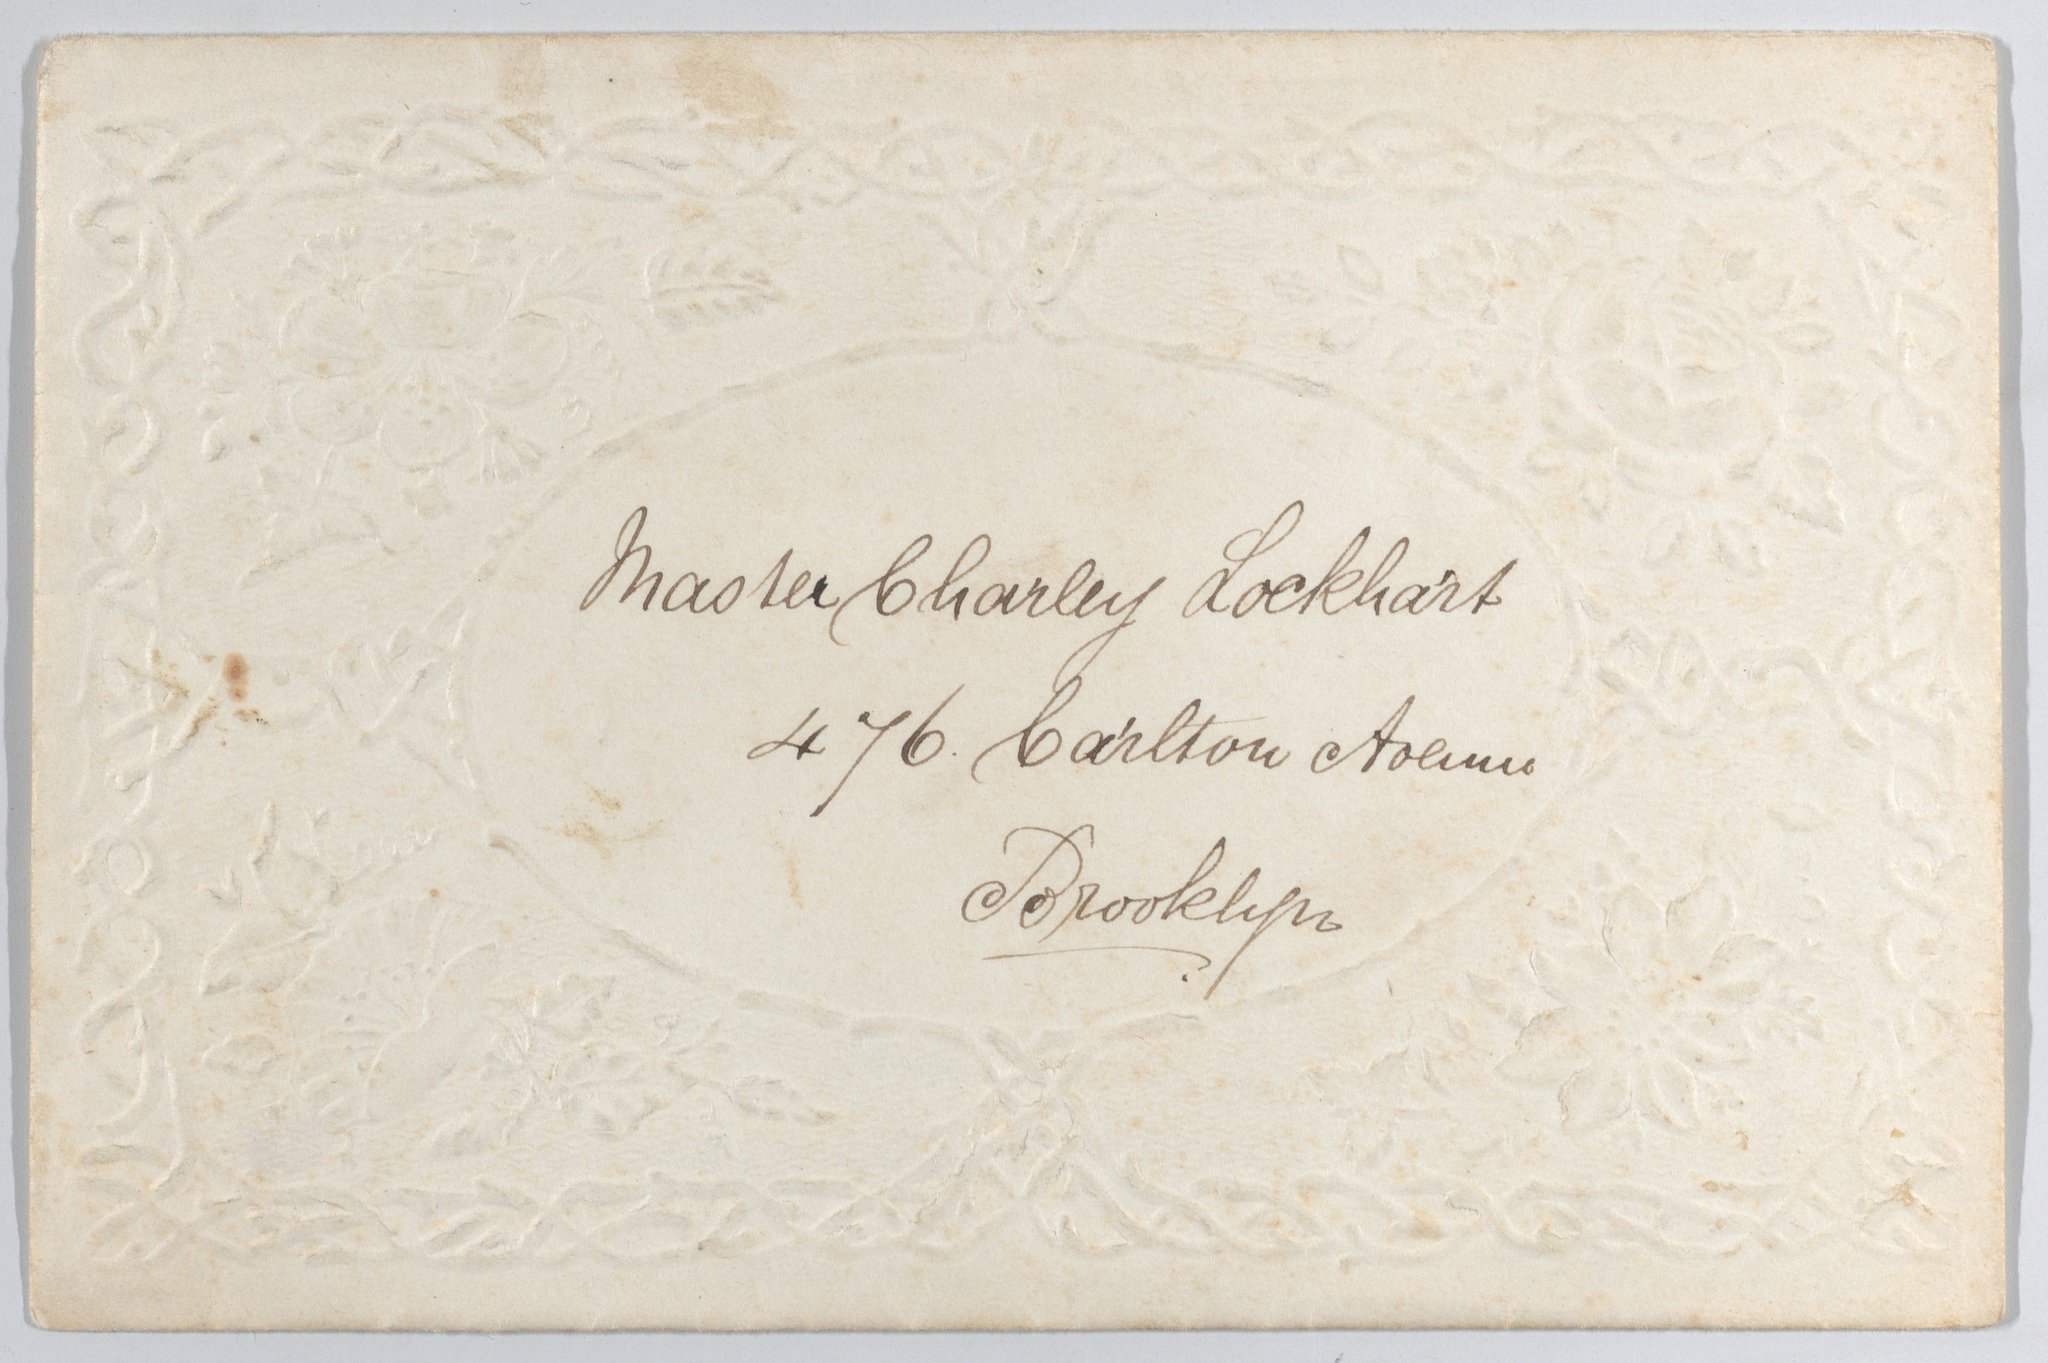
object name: valentine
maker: Anonymous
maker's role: artist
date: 1850-1870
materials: ink, lace, paper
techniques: chromolithography, embossing, open work